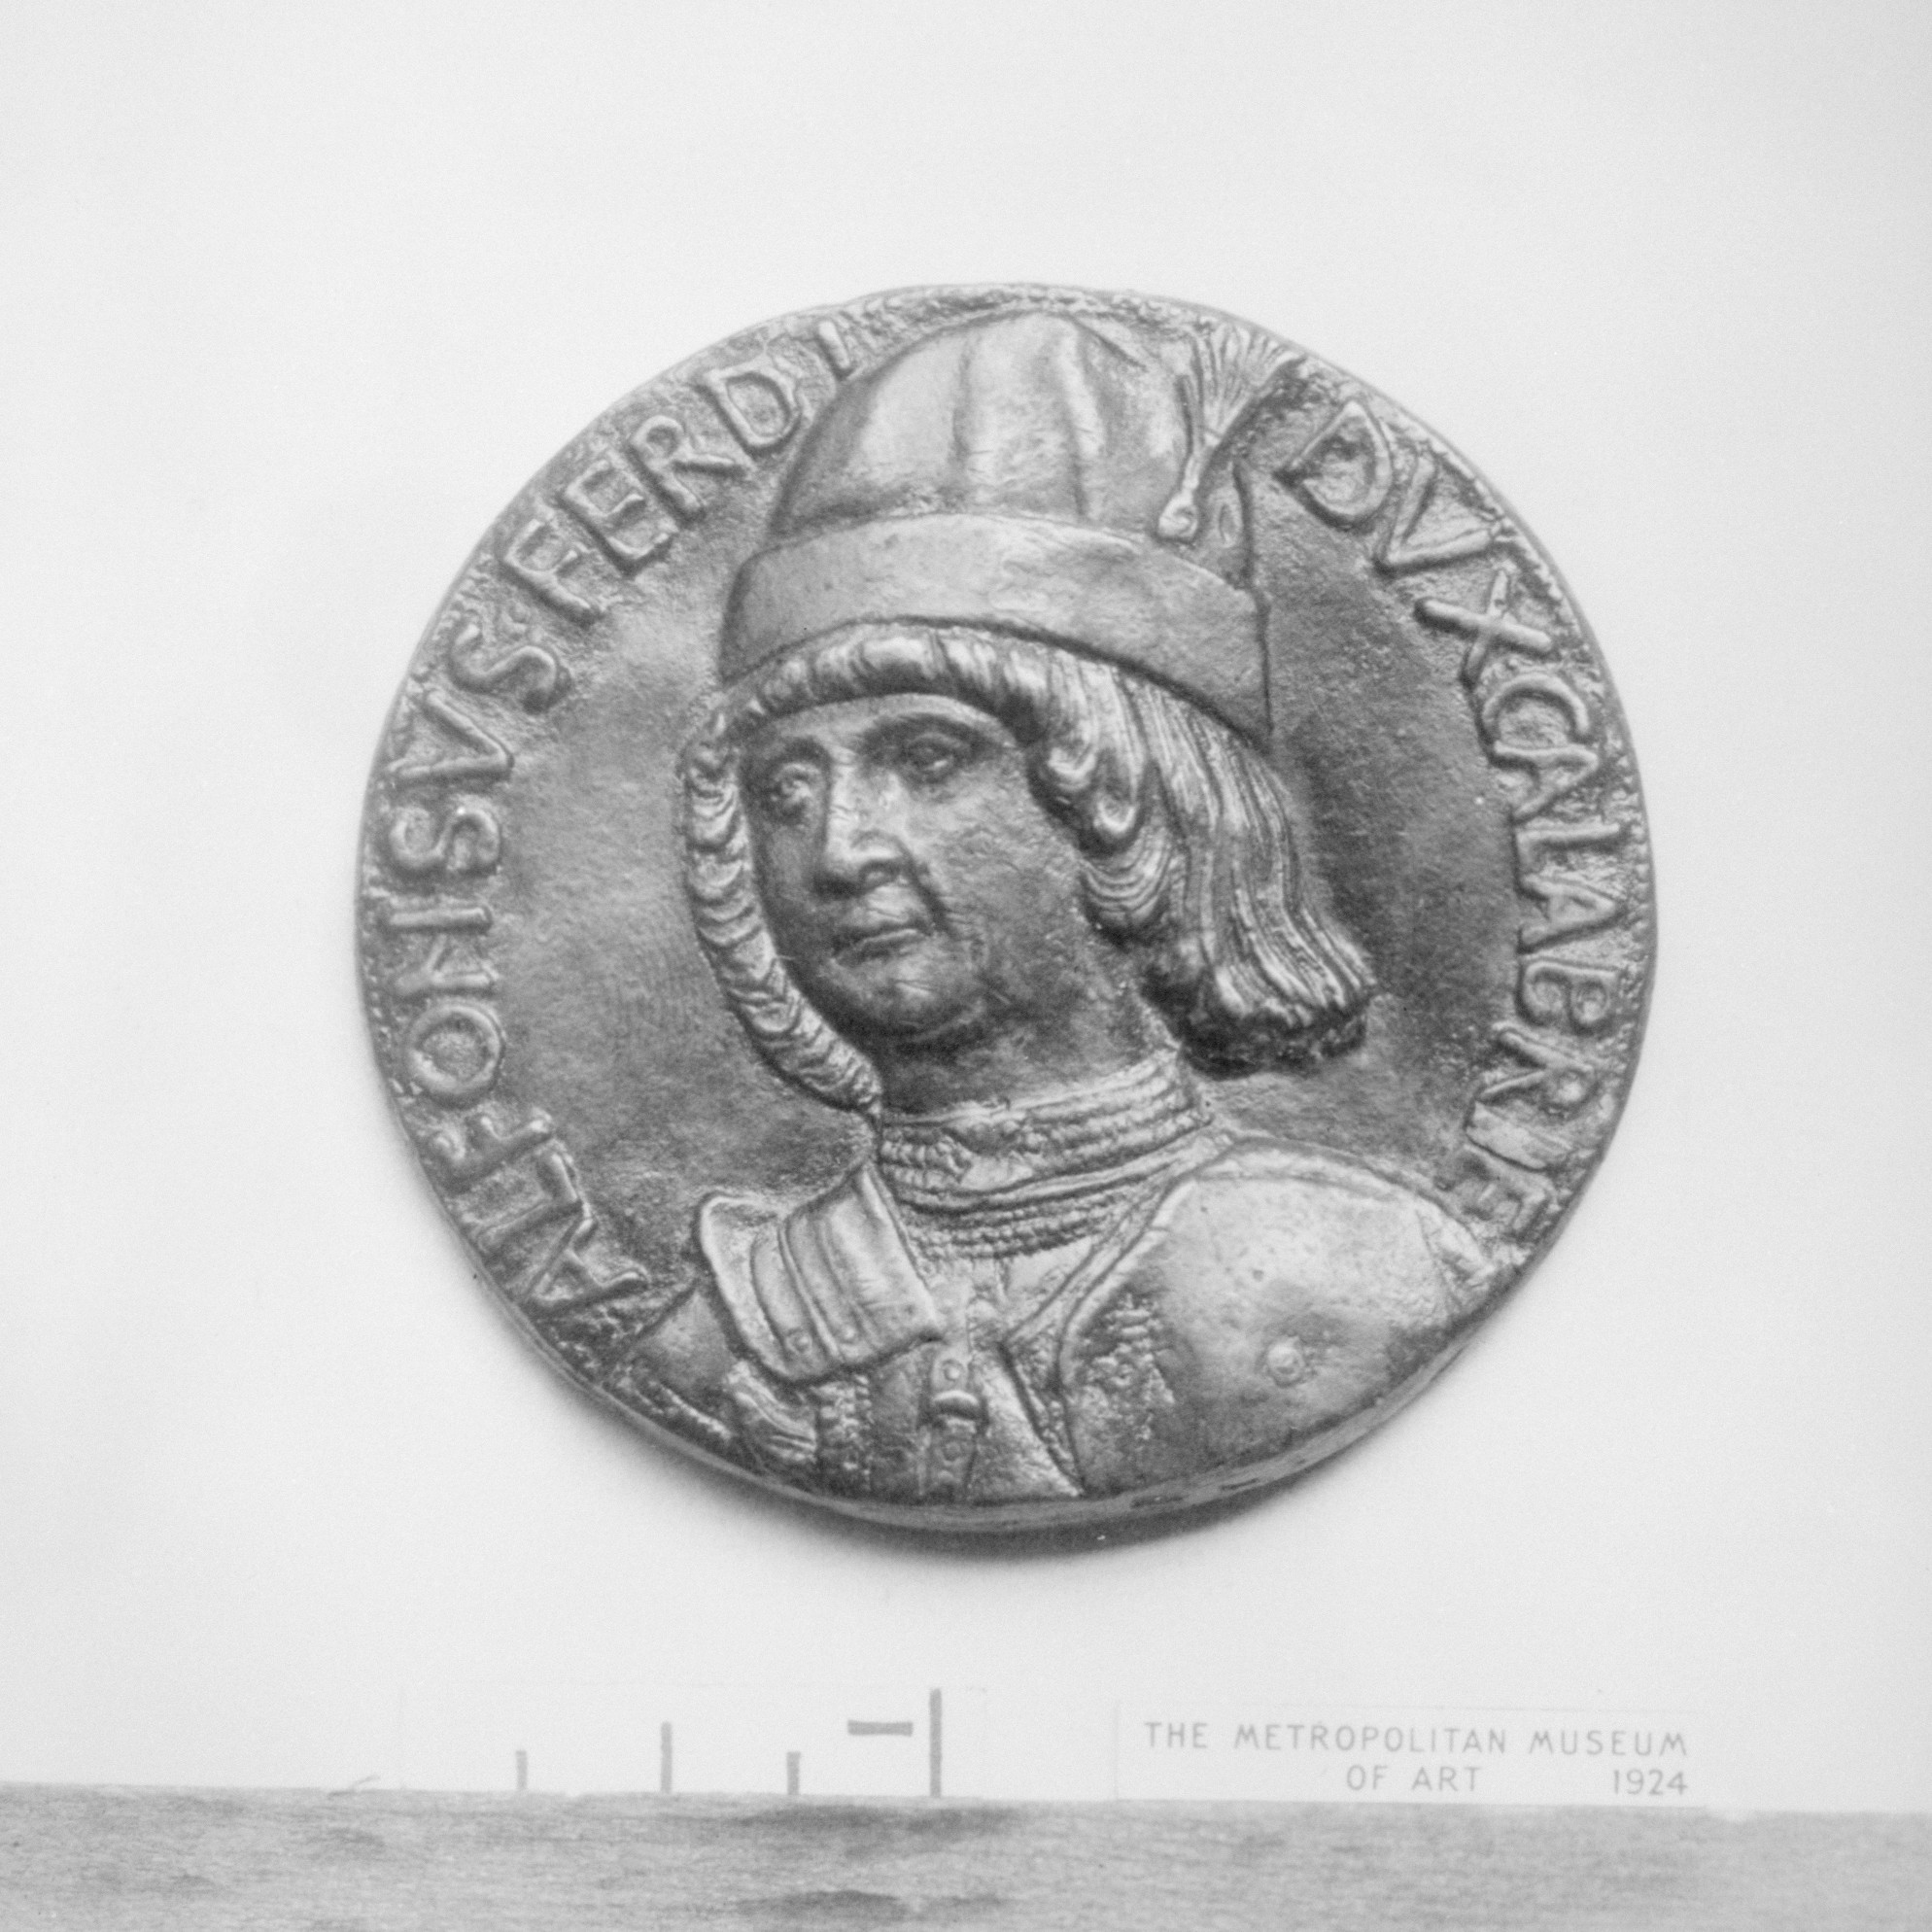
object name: medal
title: Alfonso of Aragon (1448–1495)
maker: andrea guazzalotti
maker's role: artist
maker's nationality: italian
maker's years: 1435-1495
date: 1481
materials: bronze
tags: men,portraits